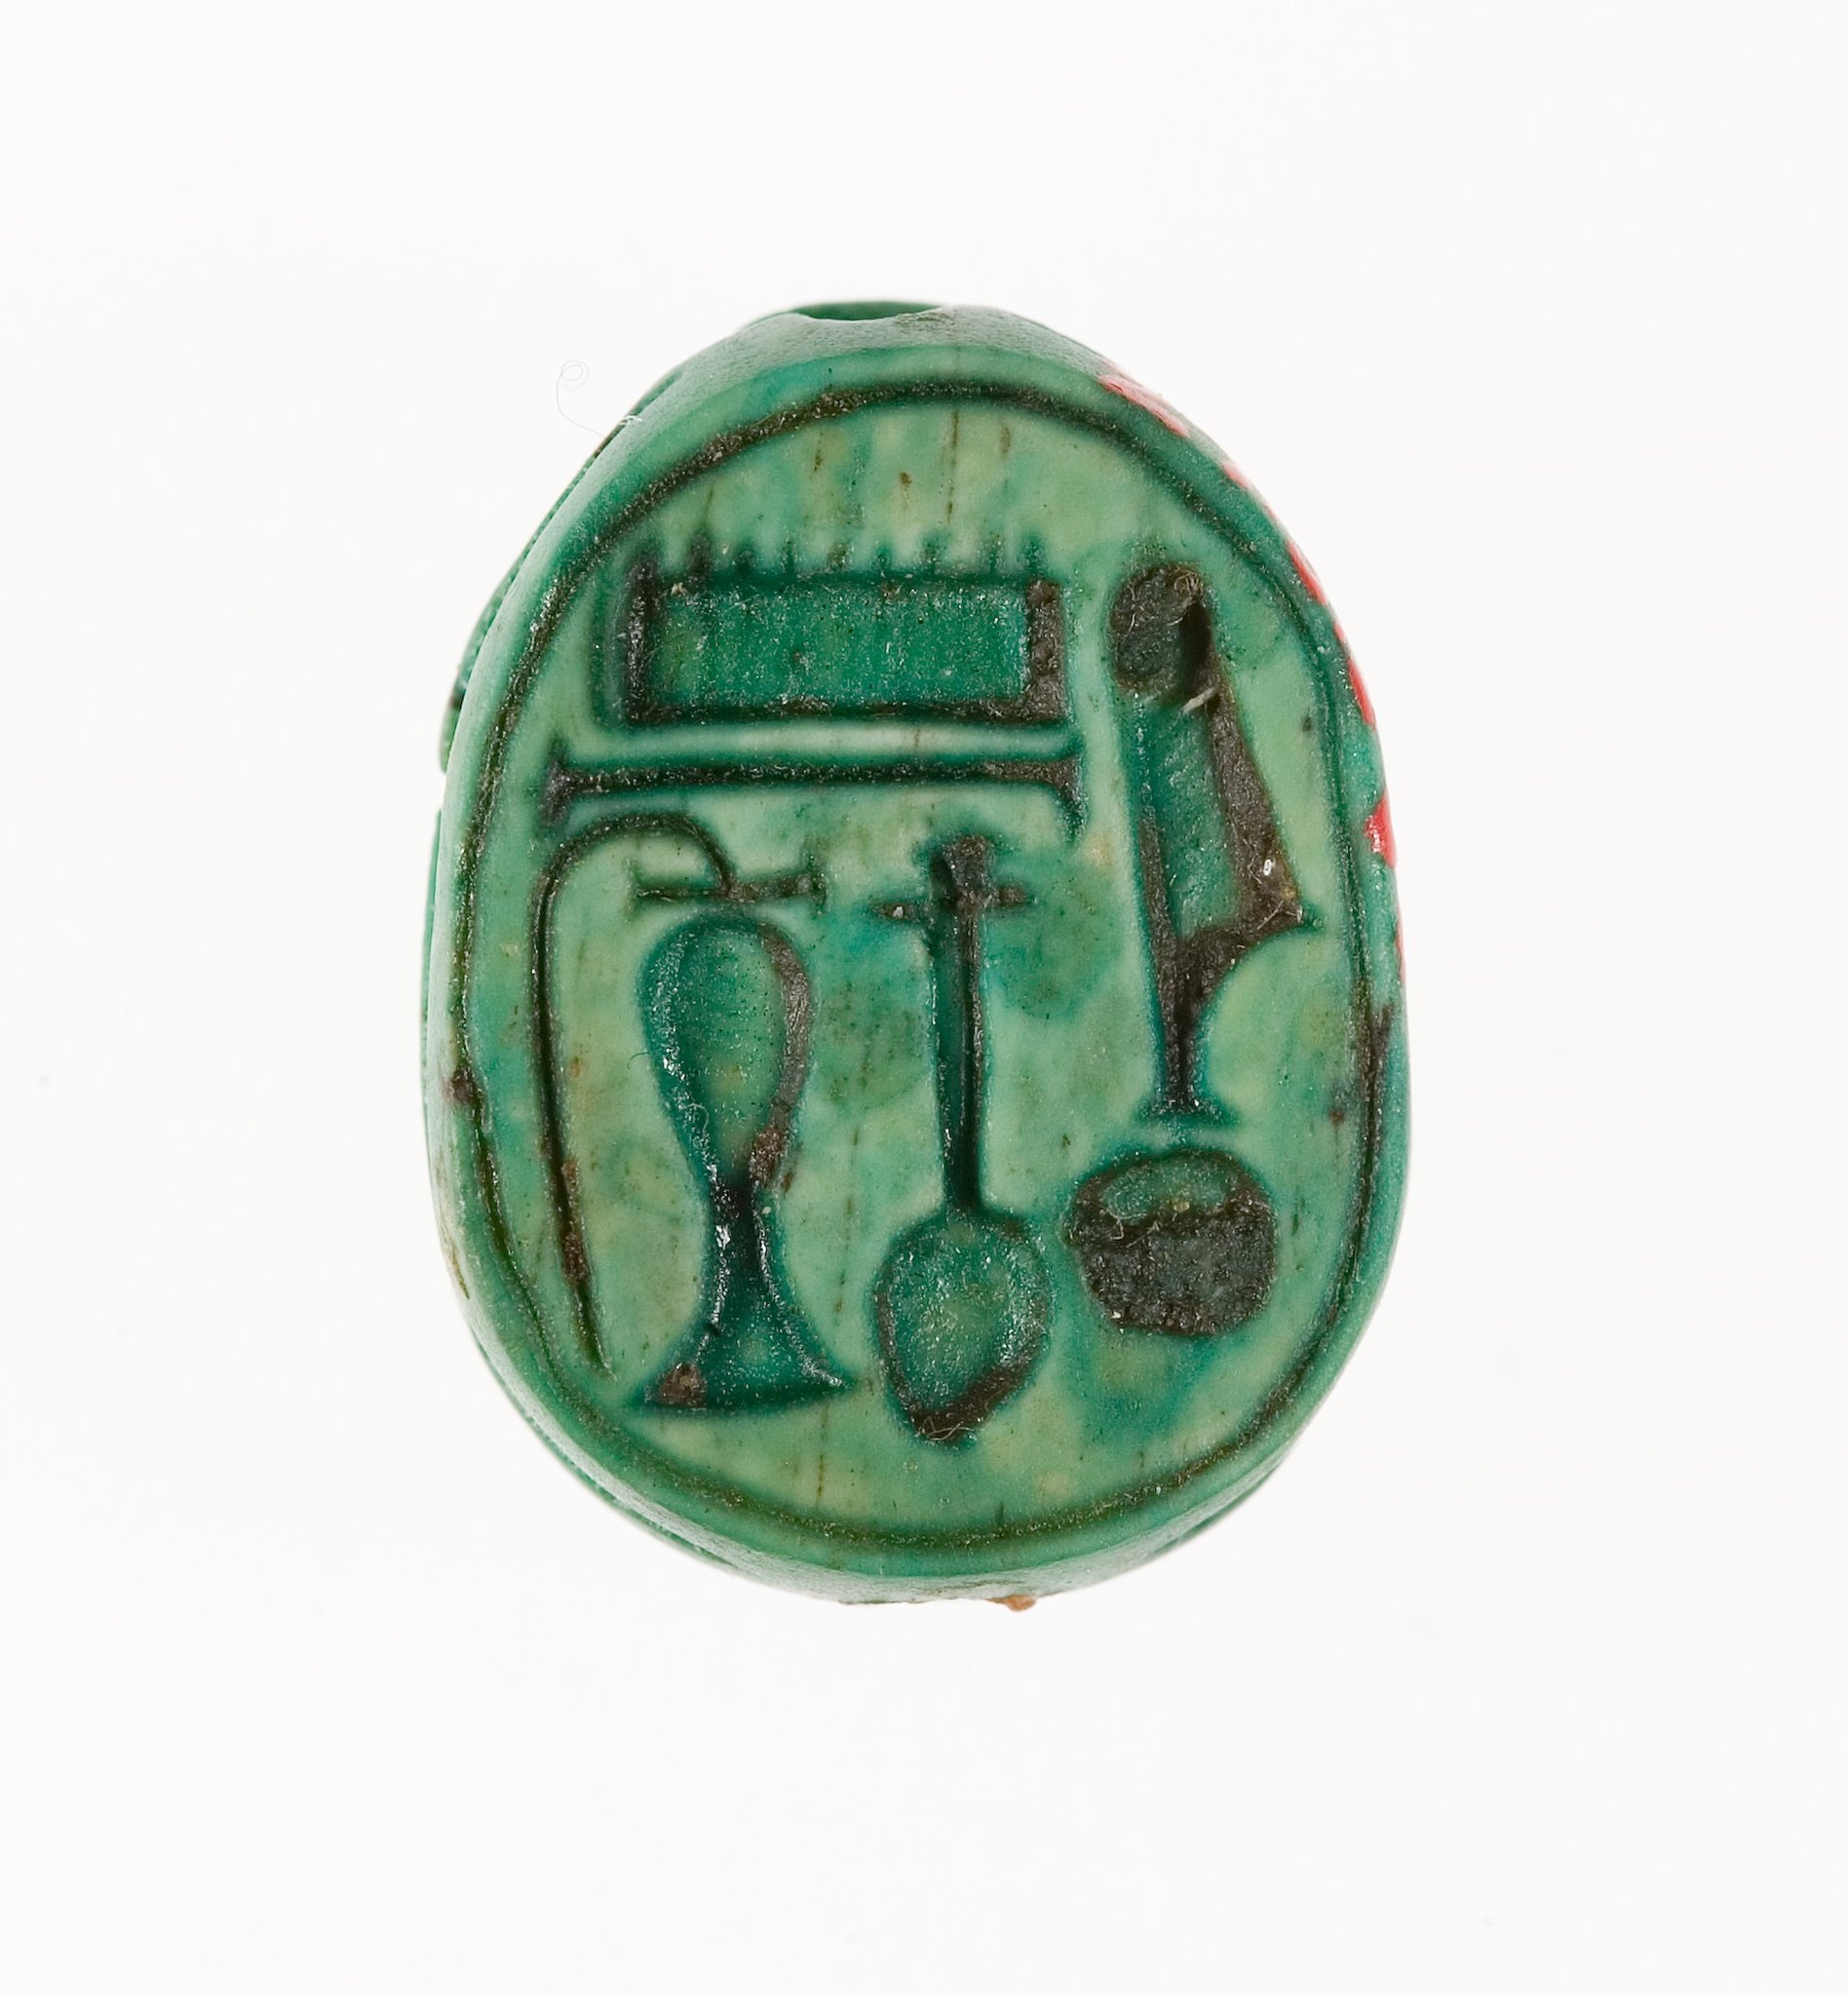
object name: scarab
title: Scarab Inscribed with the Name of the God Amun-Re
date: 1479-1458 BCE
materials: stone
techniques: glazing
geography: egypt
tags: hieroglyphs,scarabs